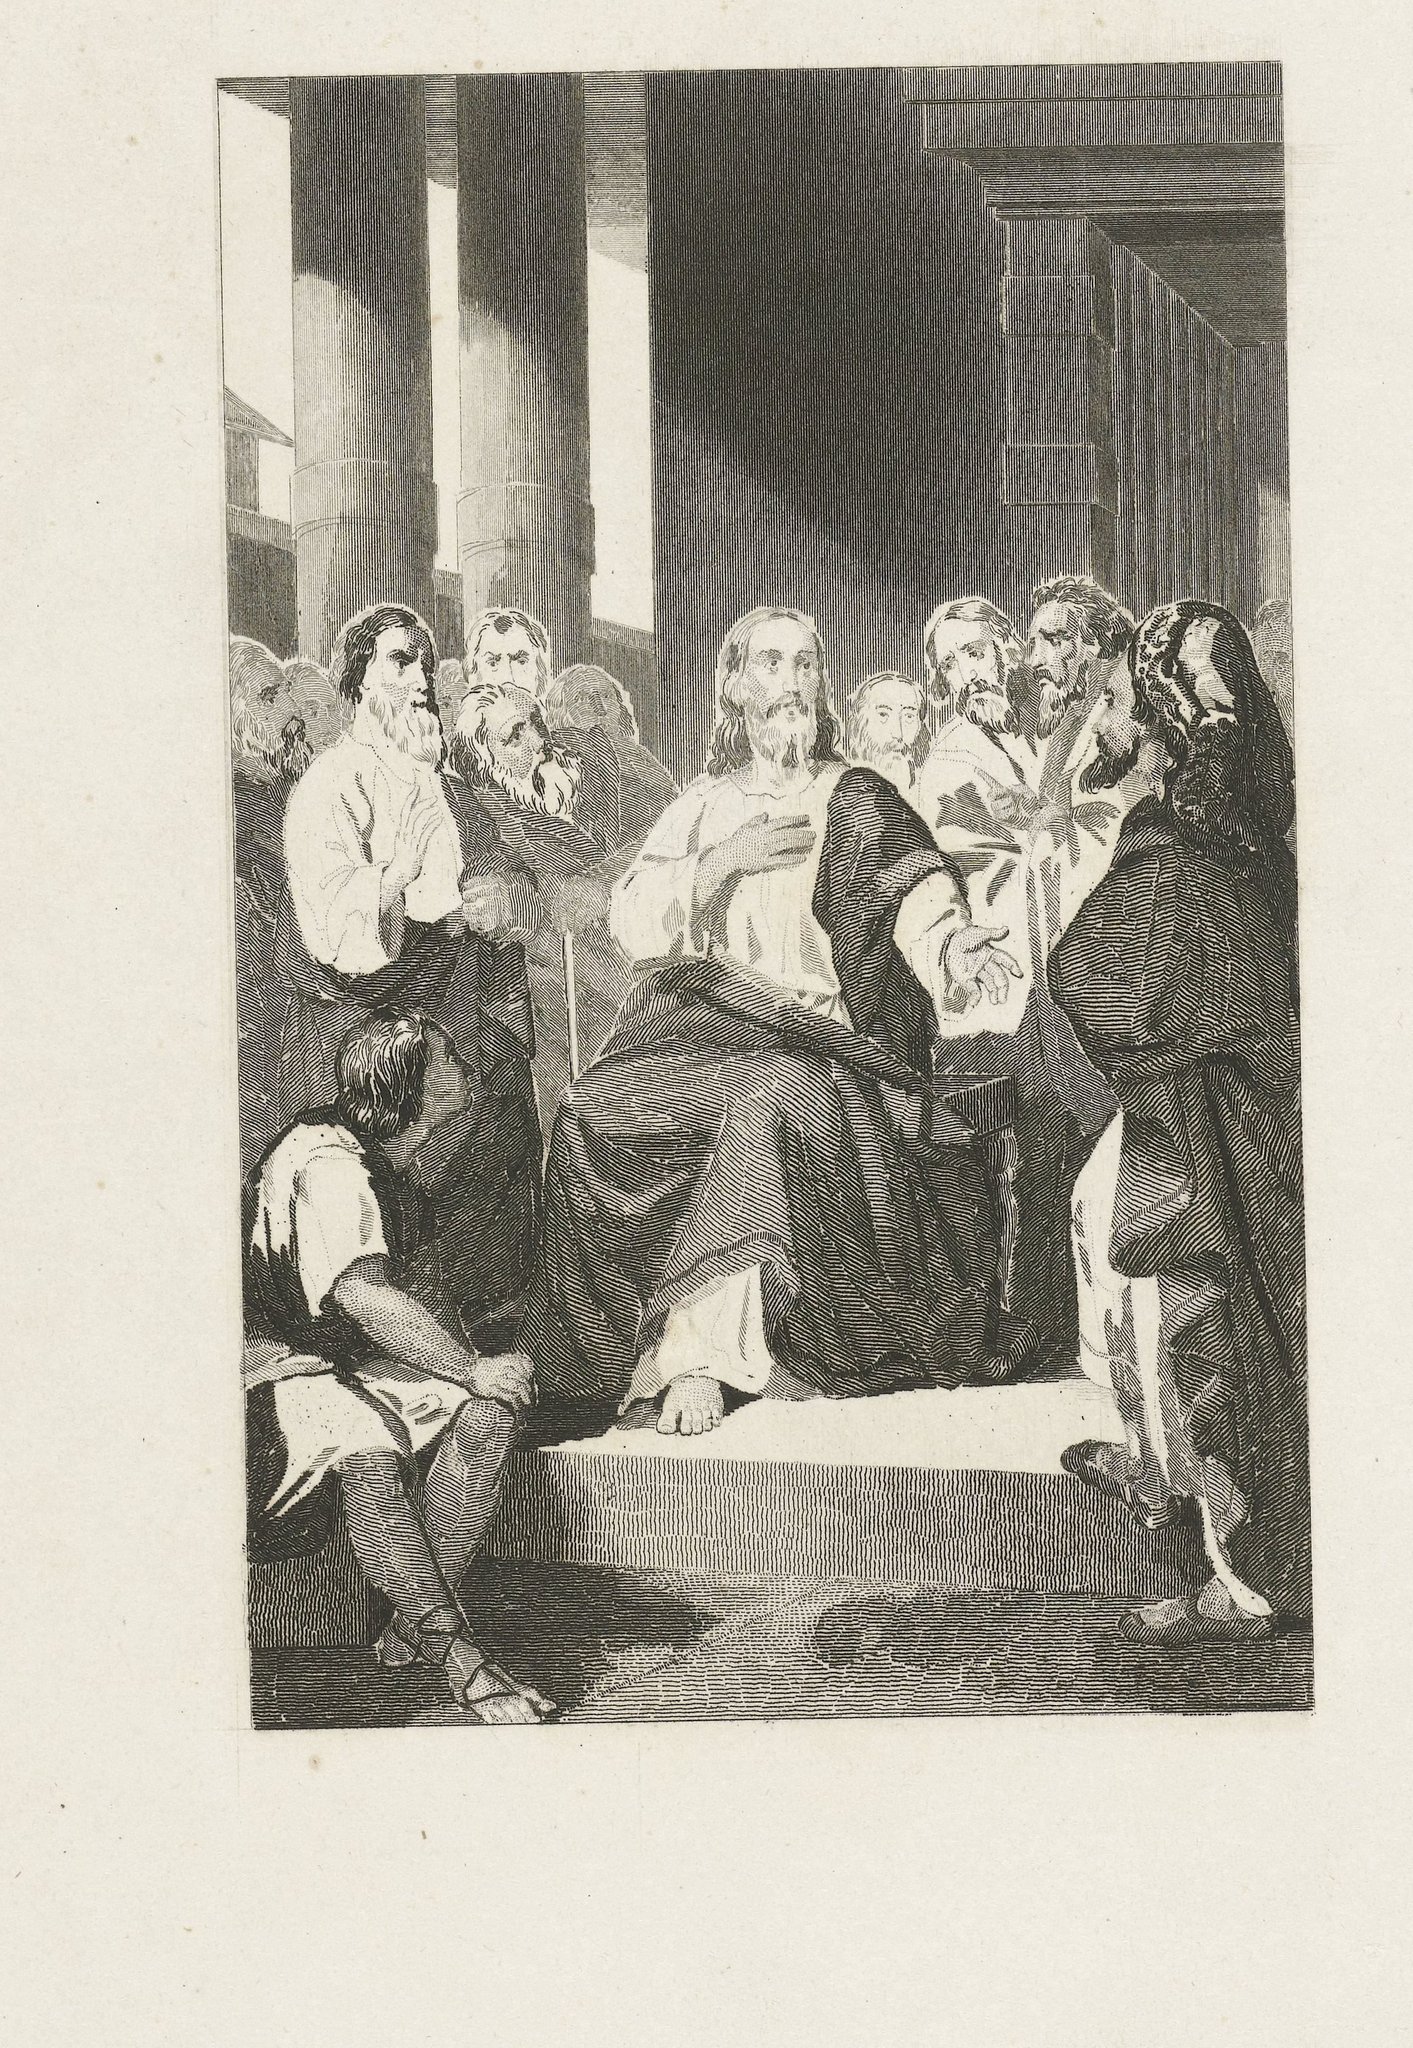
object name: print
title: Christus disputeert met mannen in de tempel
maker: henricus wilhelmus couwenberg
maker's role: draughtsman, print maker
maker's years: 1814-1845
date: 1830-1840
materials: paper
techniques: engraving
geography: amsterdam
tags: christ explaining his doctrine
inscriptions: collector's mark: Lugt 2228